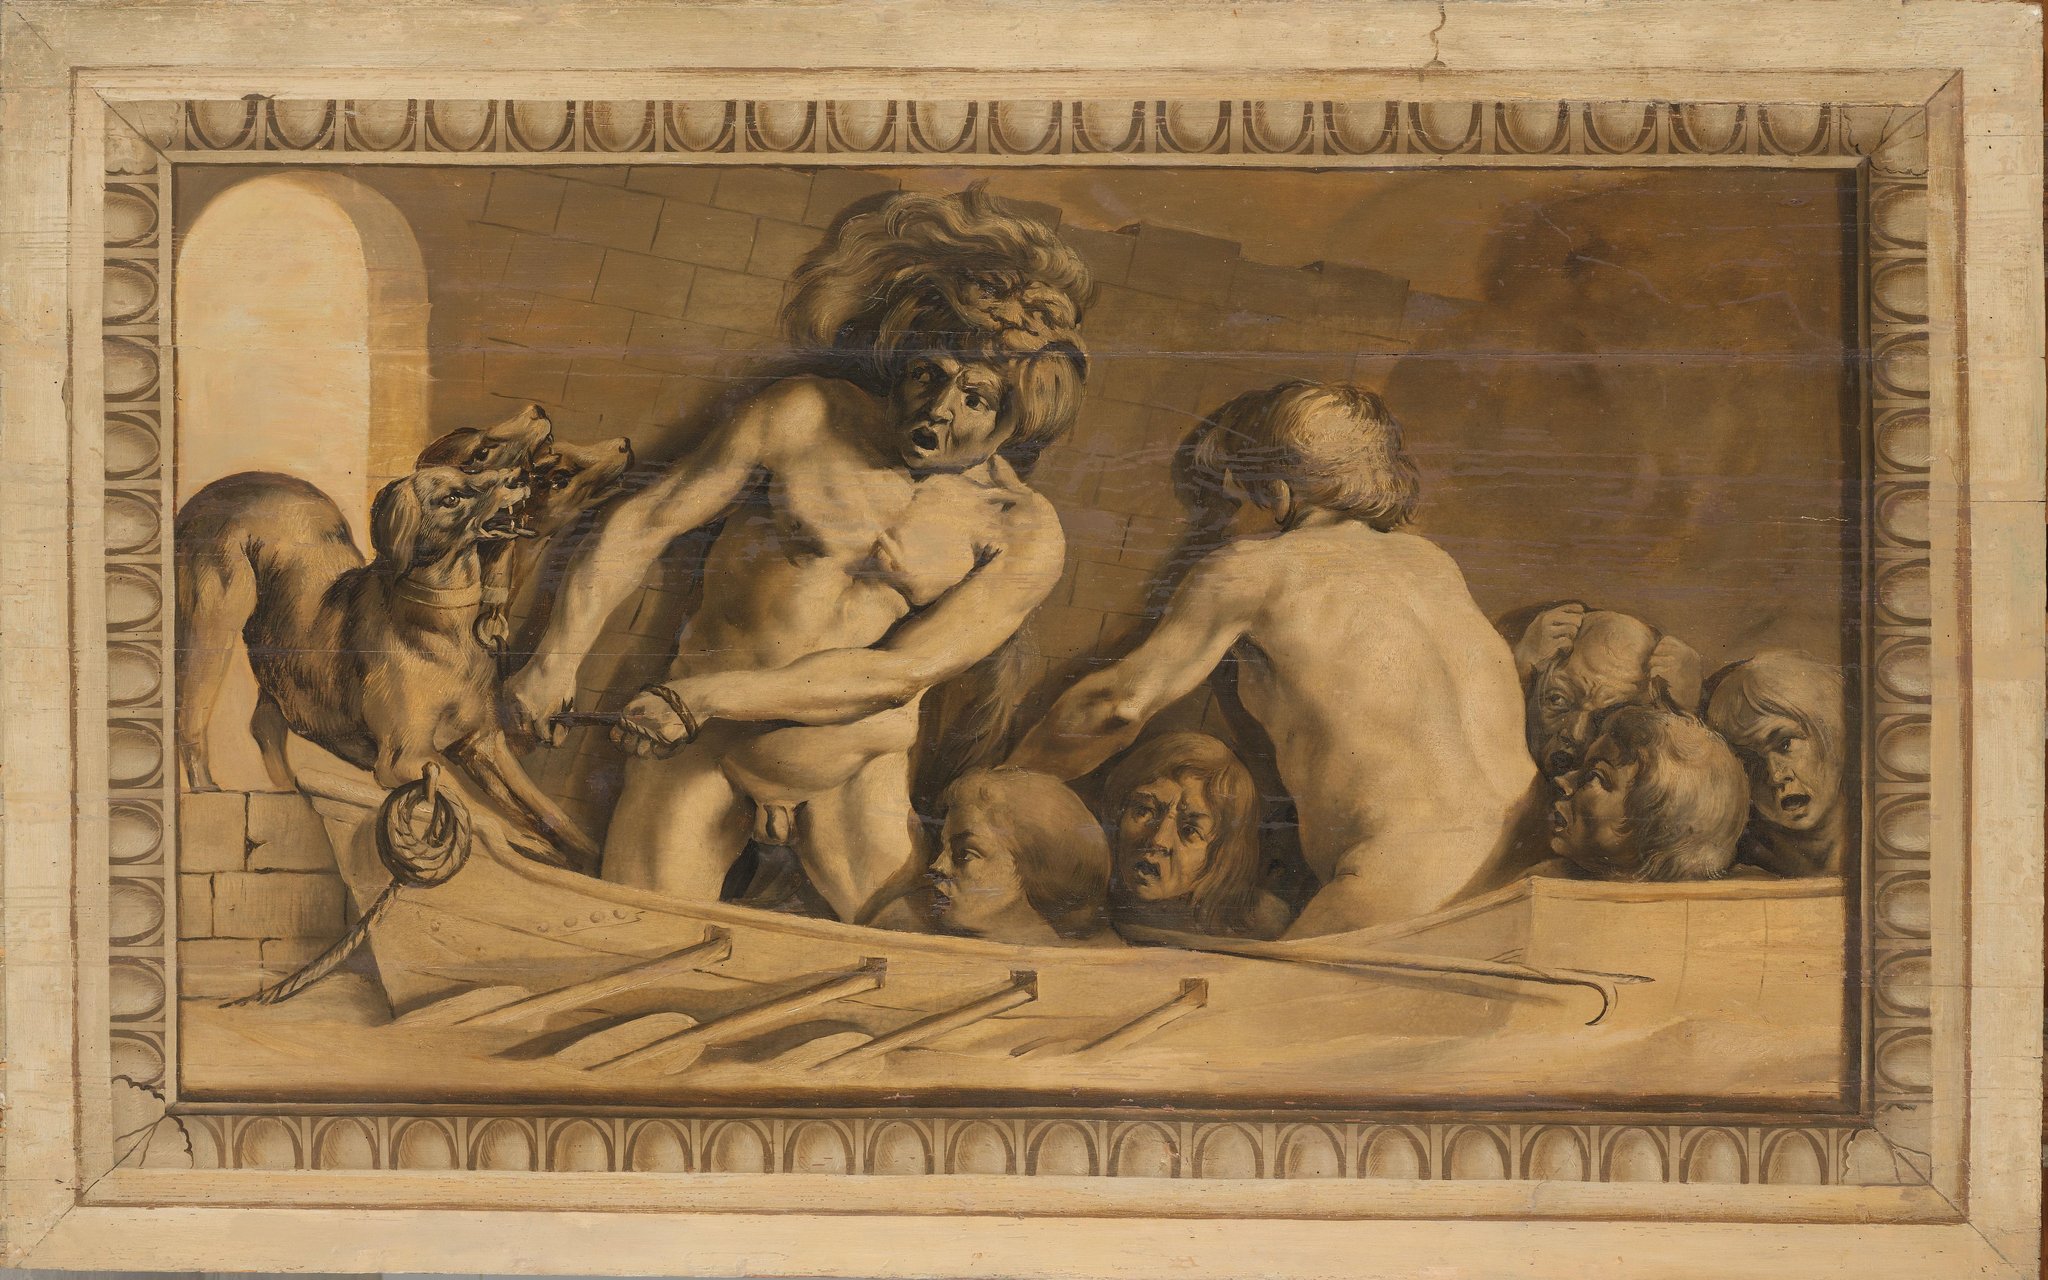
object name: wall decoration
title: Hercules Gets Cerberus from the Underworld (Charon, the Ferryman of the Styx)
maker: jacob van campen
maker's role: draughtsman, print maker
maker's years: 1595-1657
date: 1645-1650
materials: oil, panel, board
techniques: grisaille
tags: (12) cerberus captured and carried away by hercules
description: Deel van negendelige kamerbeschildering voor het huis Beekhoven, later het Hoogerhuis genoemd, bij Randenbroek bij Amersfoort, het buitenhuis van Jacob van Campen.